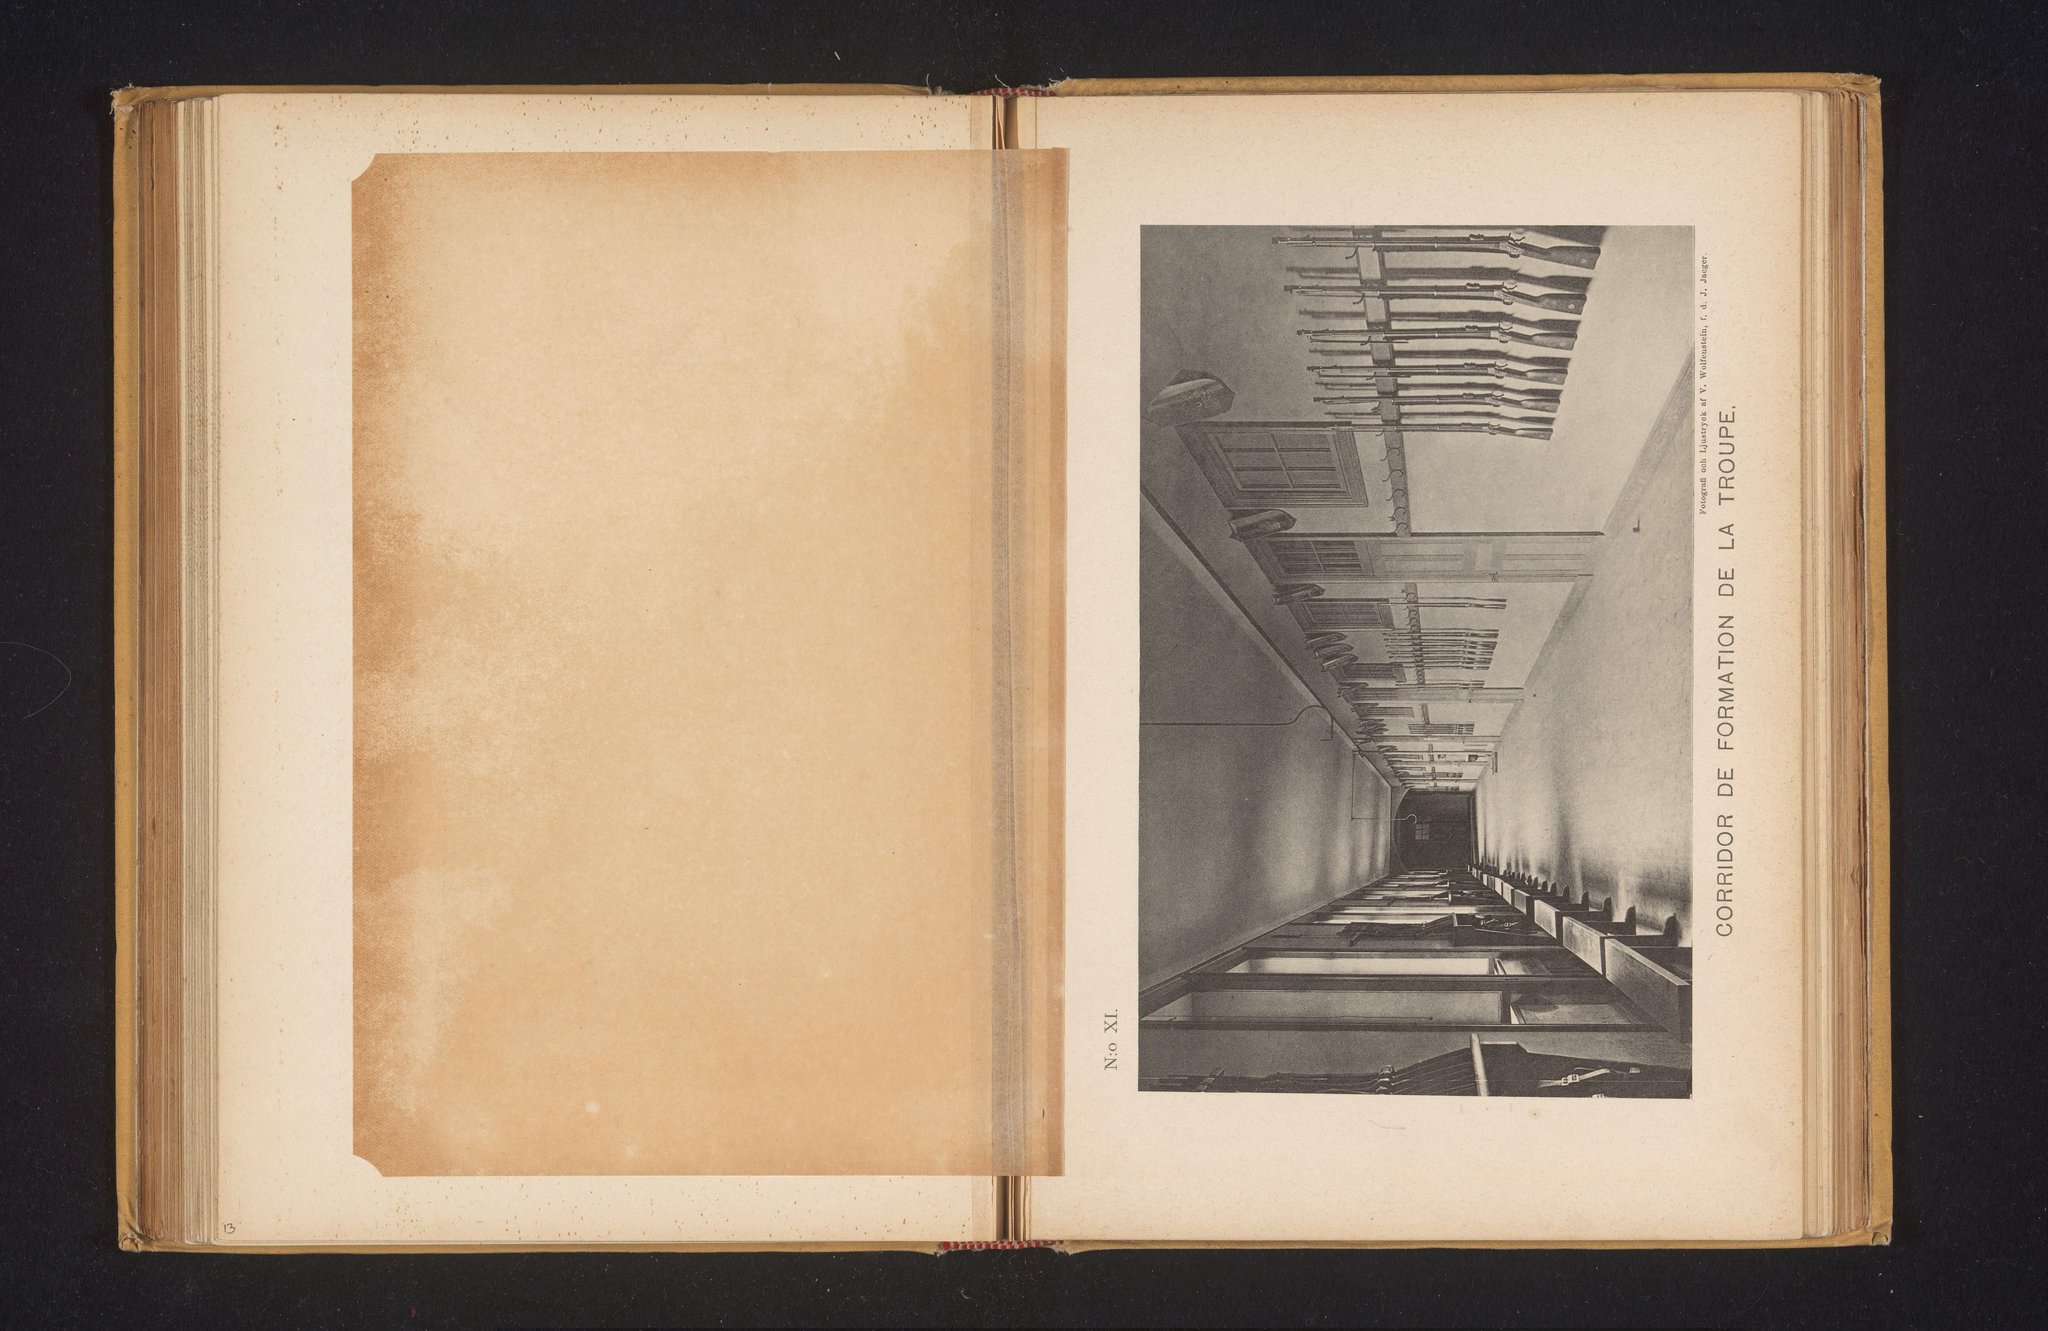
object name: photomechanical print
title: Corridor de formation de la troupe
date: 1888-1891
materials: paper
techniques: photograph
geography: stockholm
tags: corridor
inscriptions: number: ‘N:o XI.’